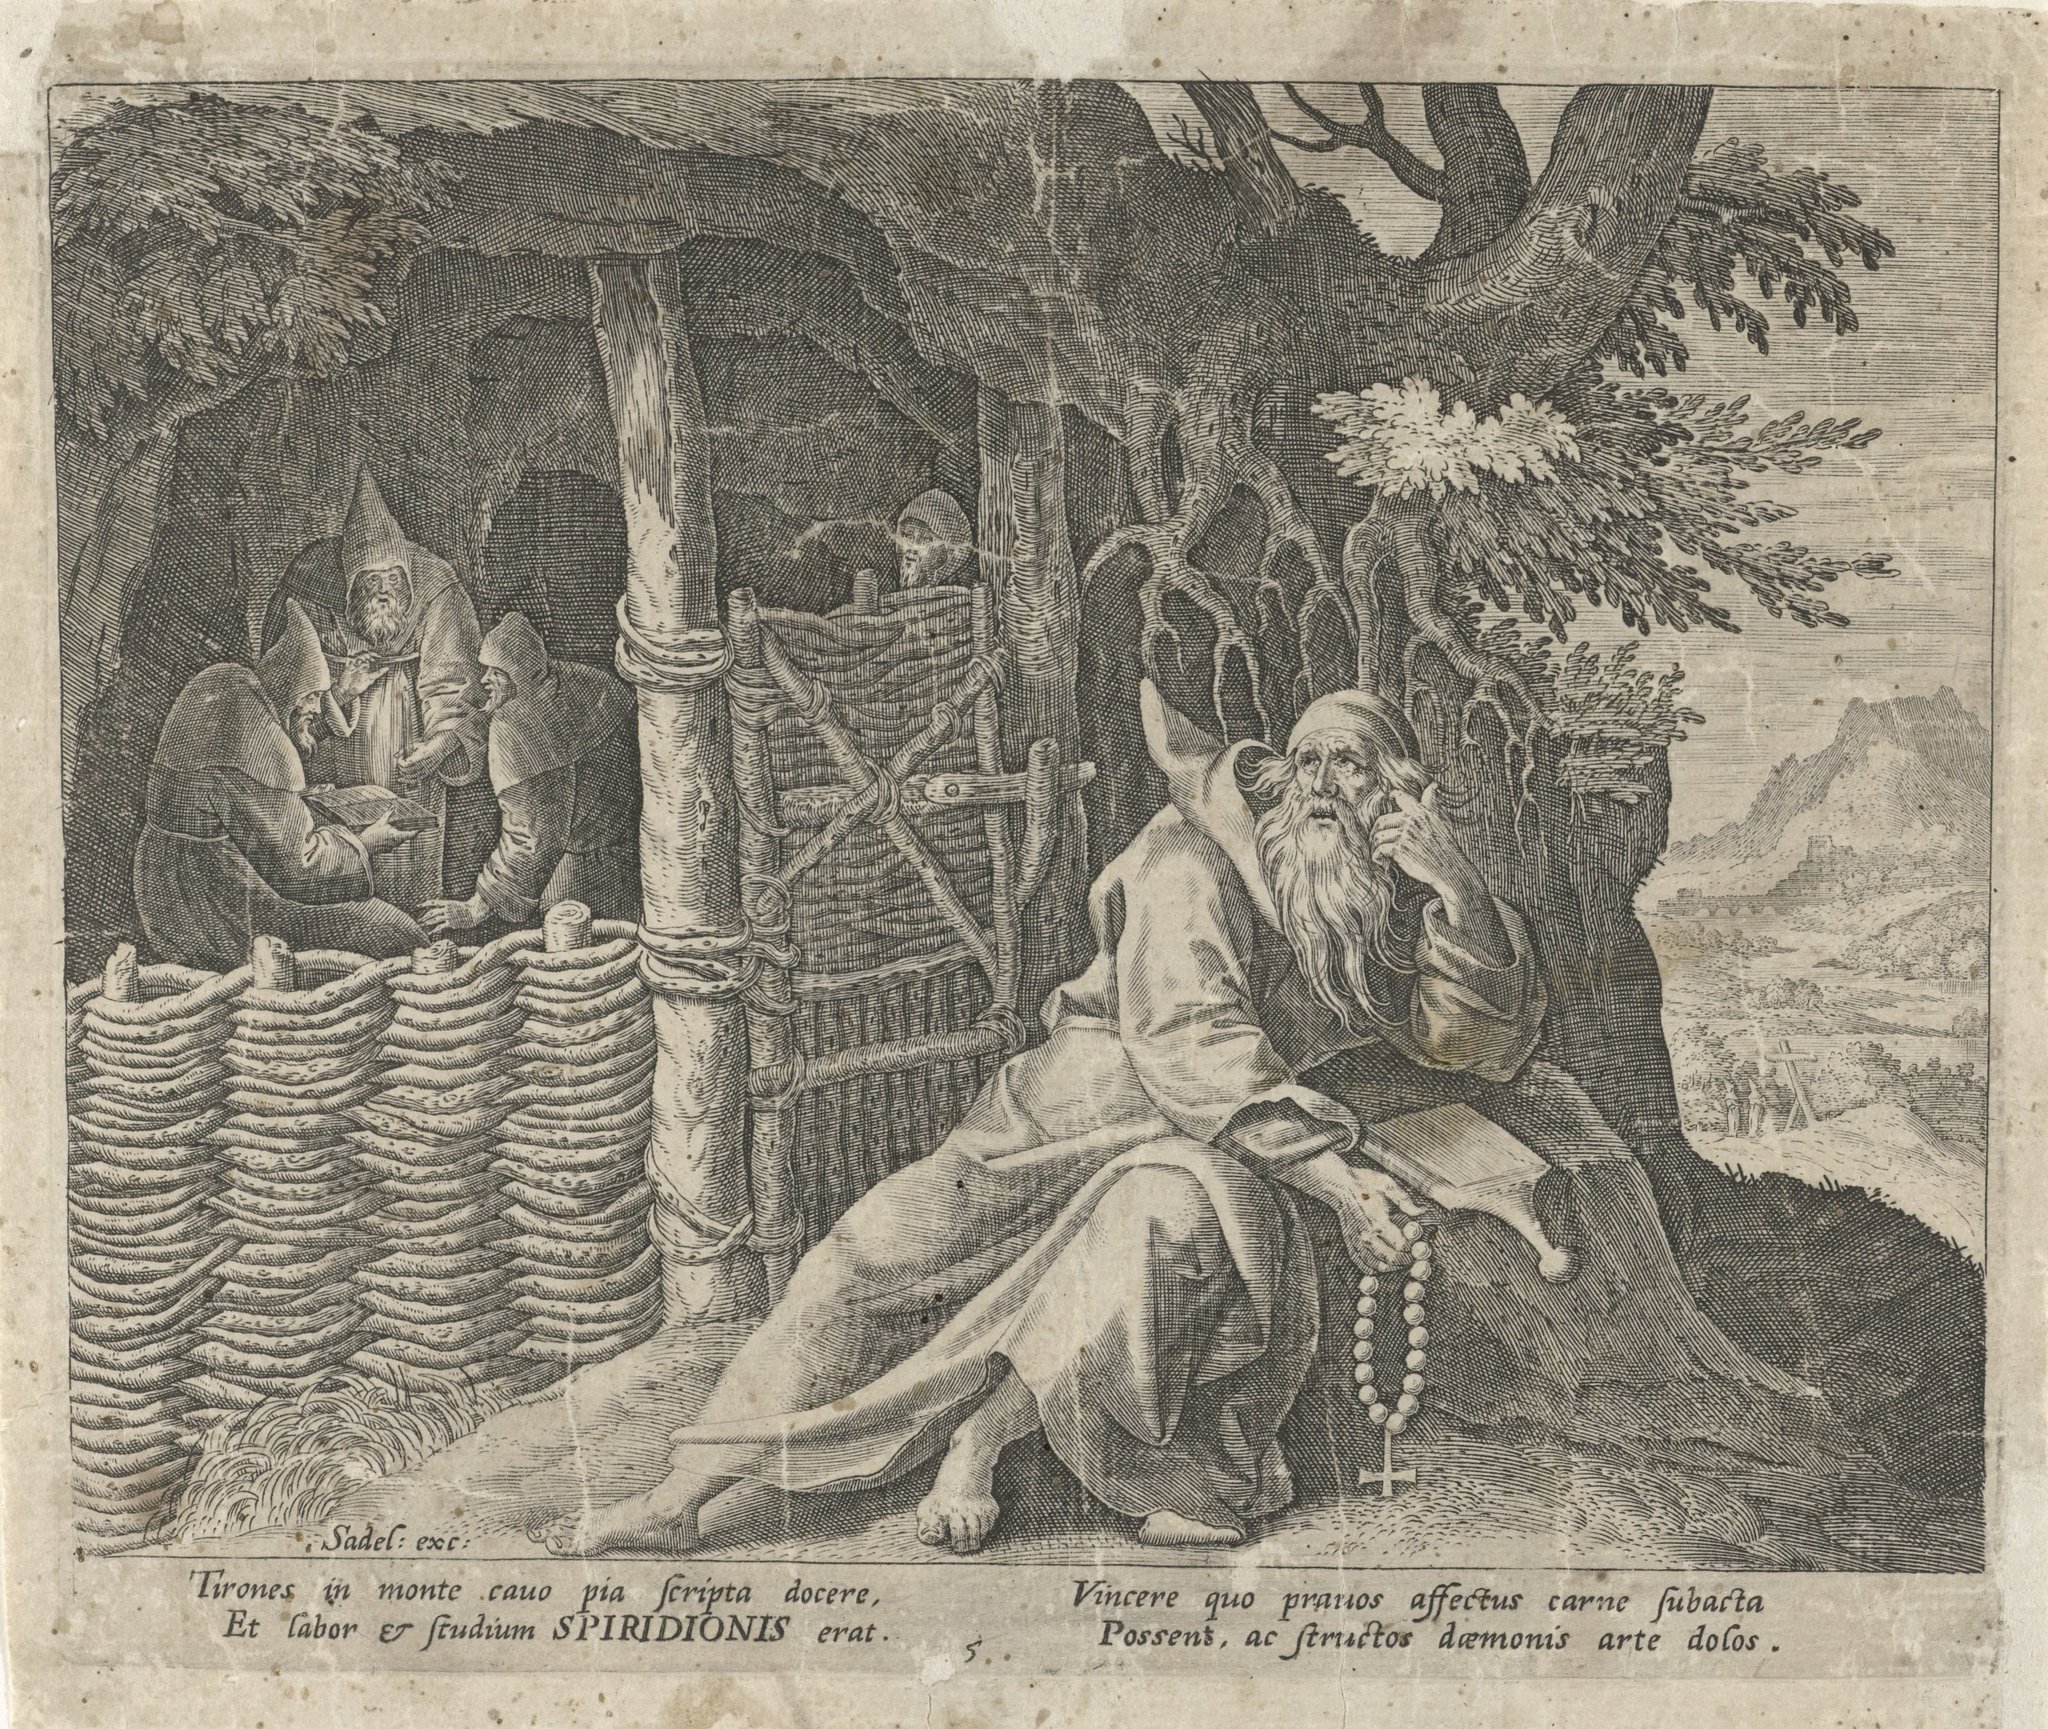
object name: print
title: Spiridon van Cyprus als kluizenaar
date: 1583-1588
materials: paper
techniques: engraving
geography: antwerp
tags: male saints (with name), anchorite, hermit, cave, grotto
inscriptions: collector's mark: Lugt 2228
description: De H. Spiridon van Cyprus voor een grot in de woestijn. Hij ligt tegen een rots en leest een bijbel. In de grot lezen drie monniken uit een bijbel.